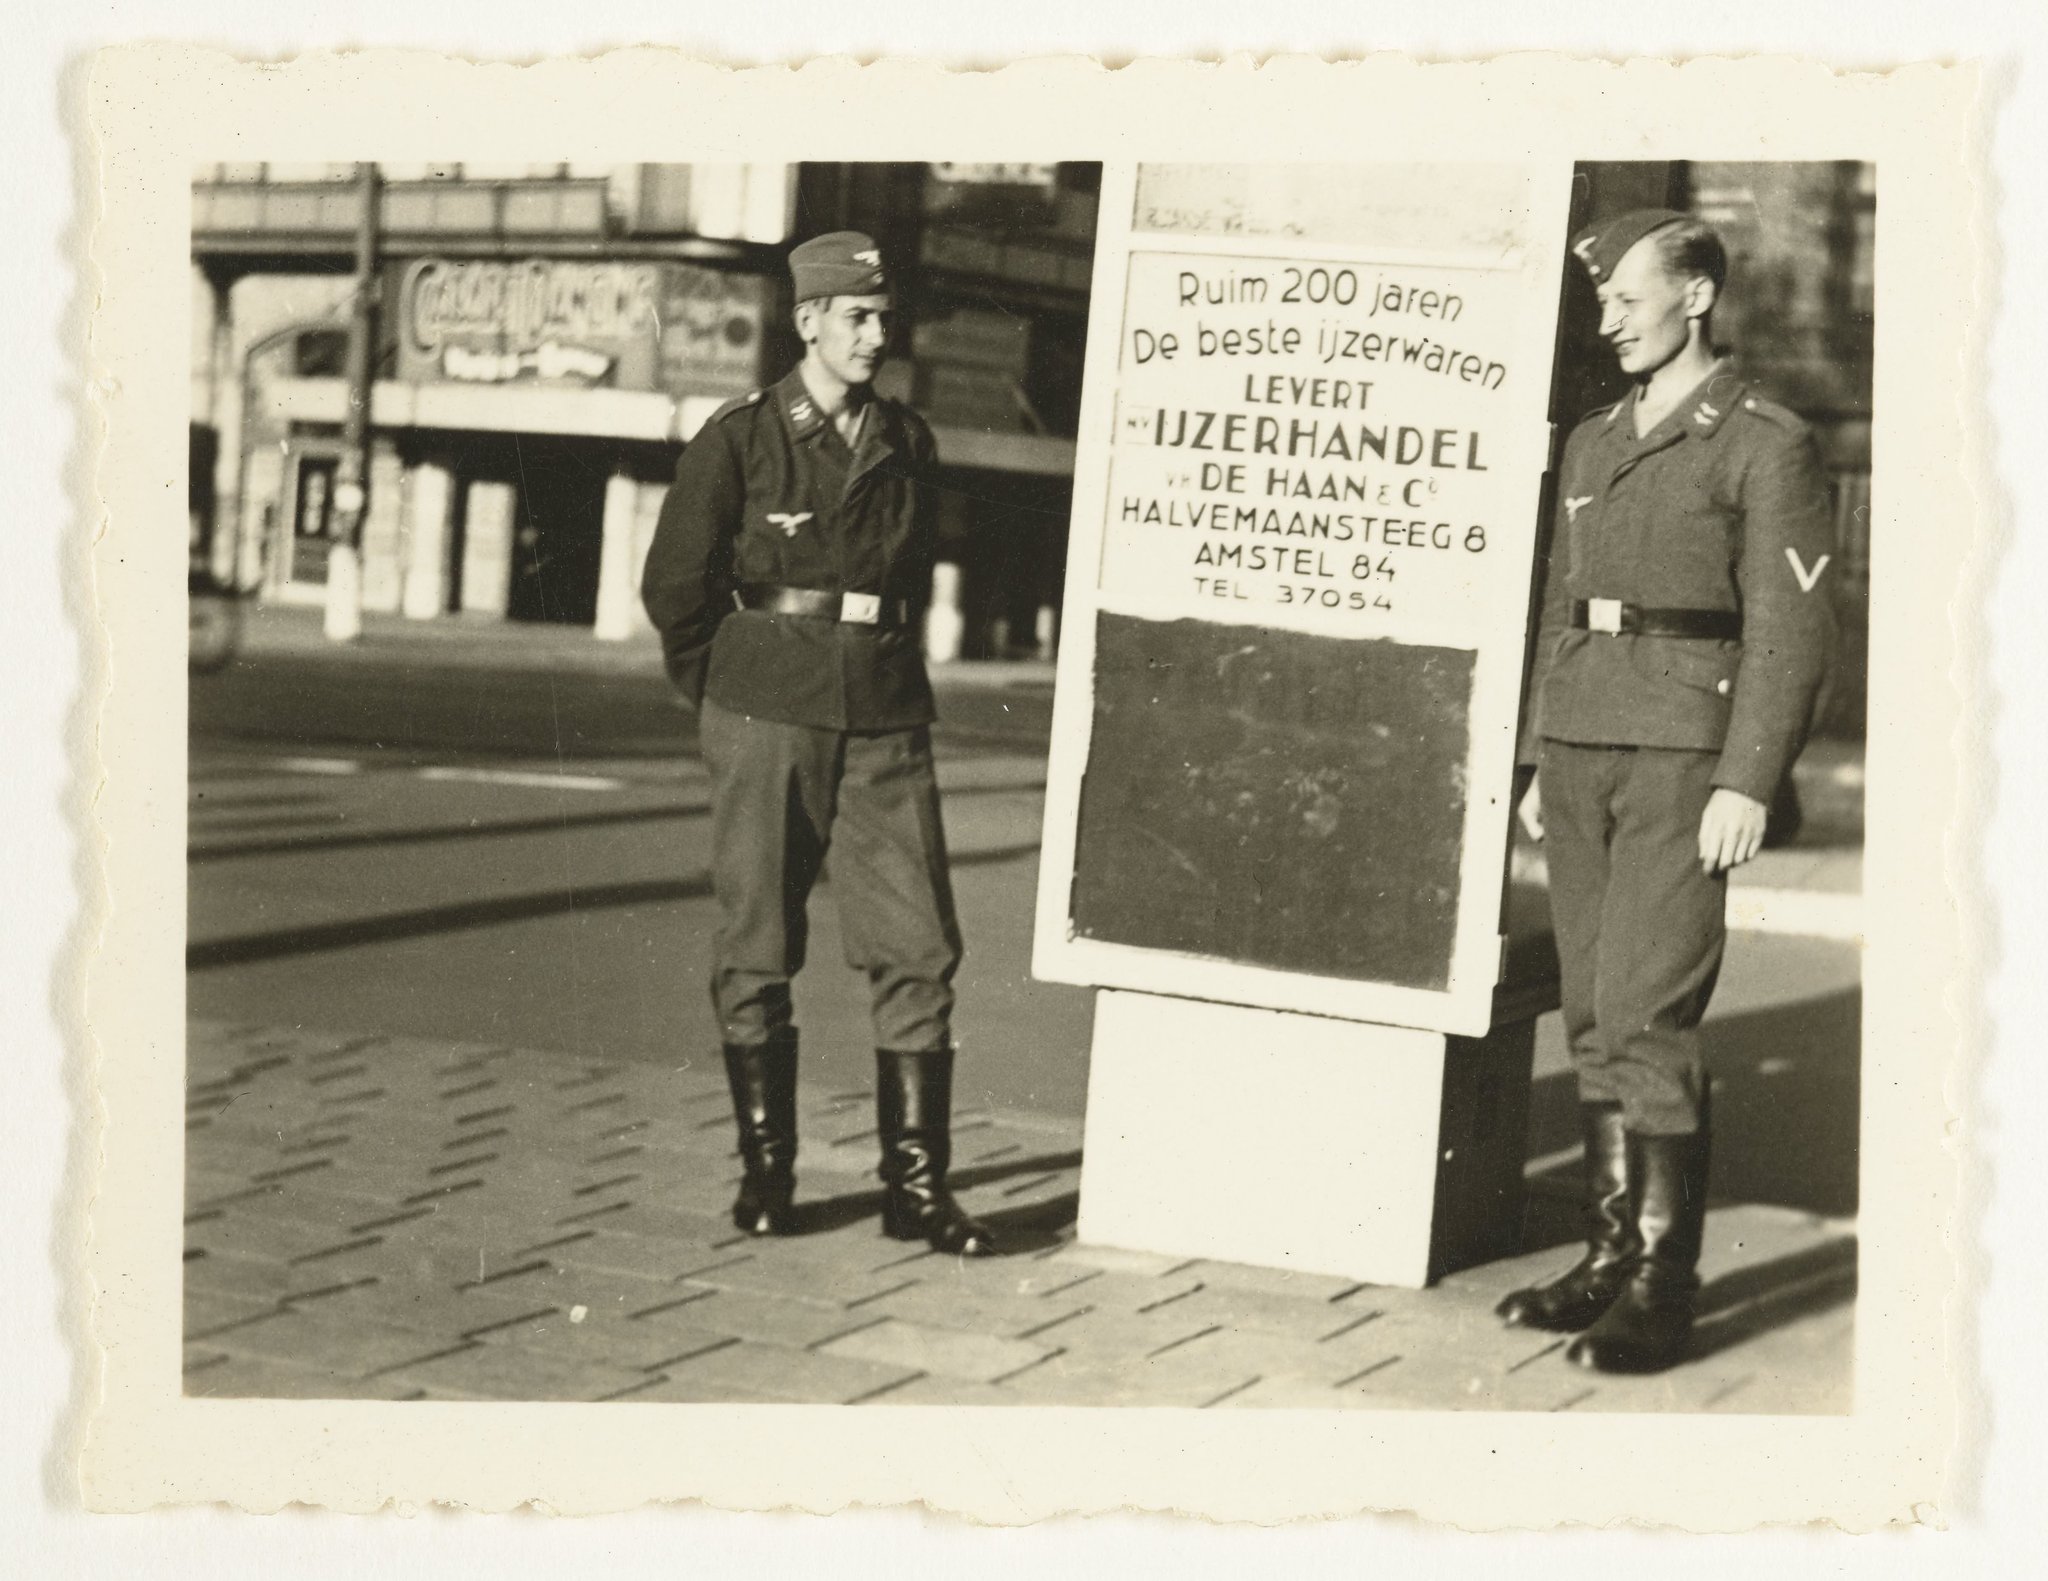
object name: photograph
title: Luftwaffe militairen op straat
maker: Anonymous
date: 1910-1941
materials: photographic support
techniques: gelatin silver print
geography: amsterdam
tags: occupation ~ war, amsterdam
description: Twee Luftwaffe militairen staan op straat bij een reclamebord voor ijzerhandel De Haan&Co in de Halvemaansteeg in Amsterdam. Zij staan dus op het Rembrandtplein.